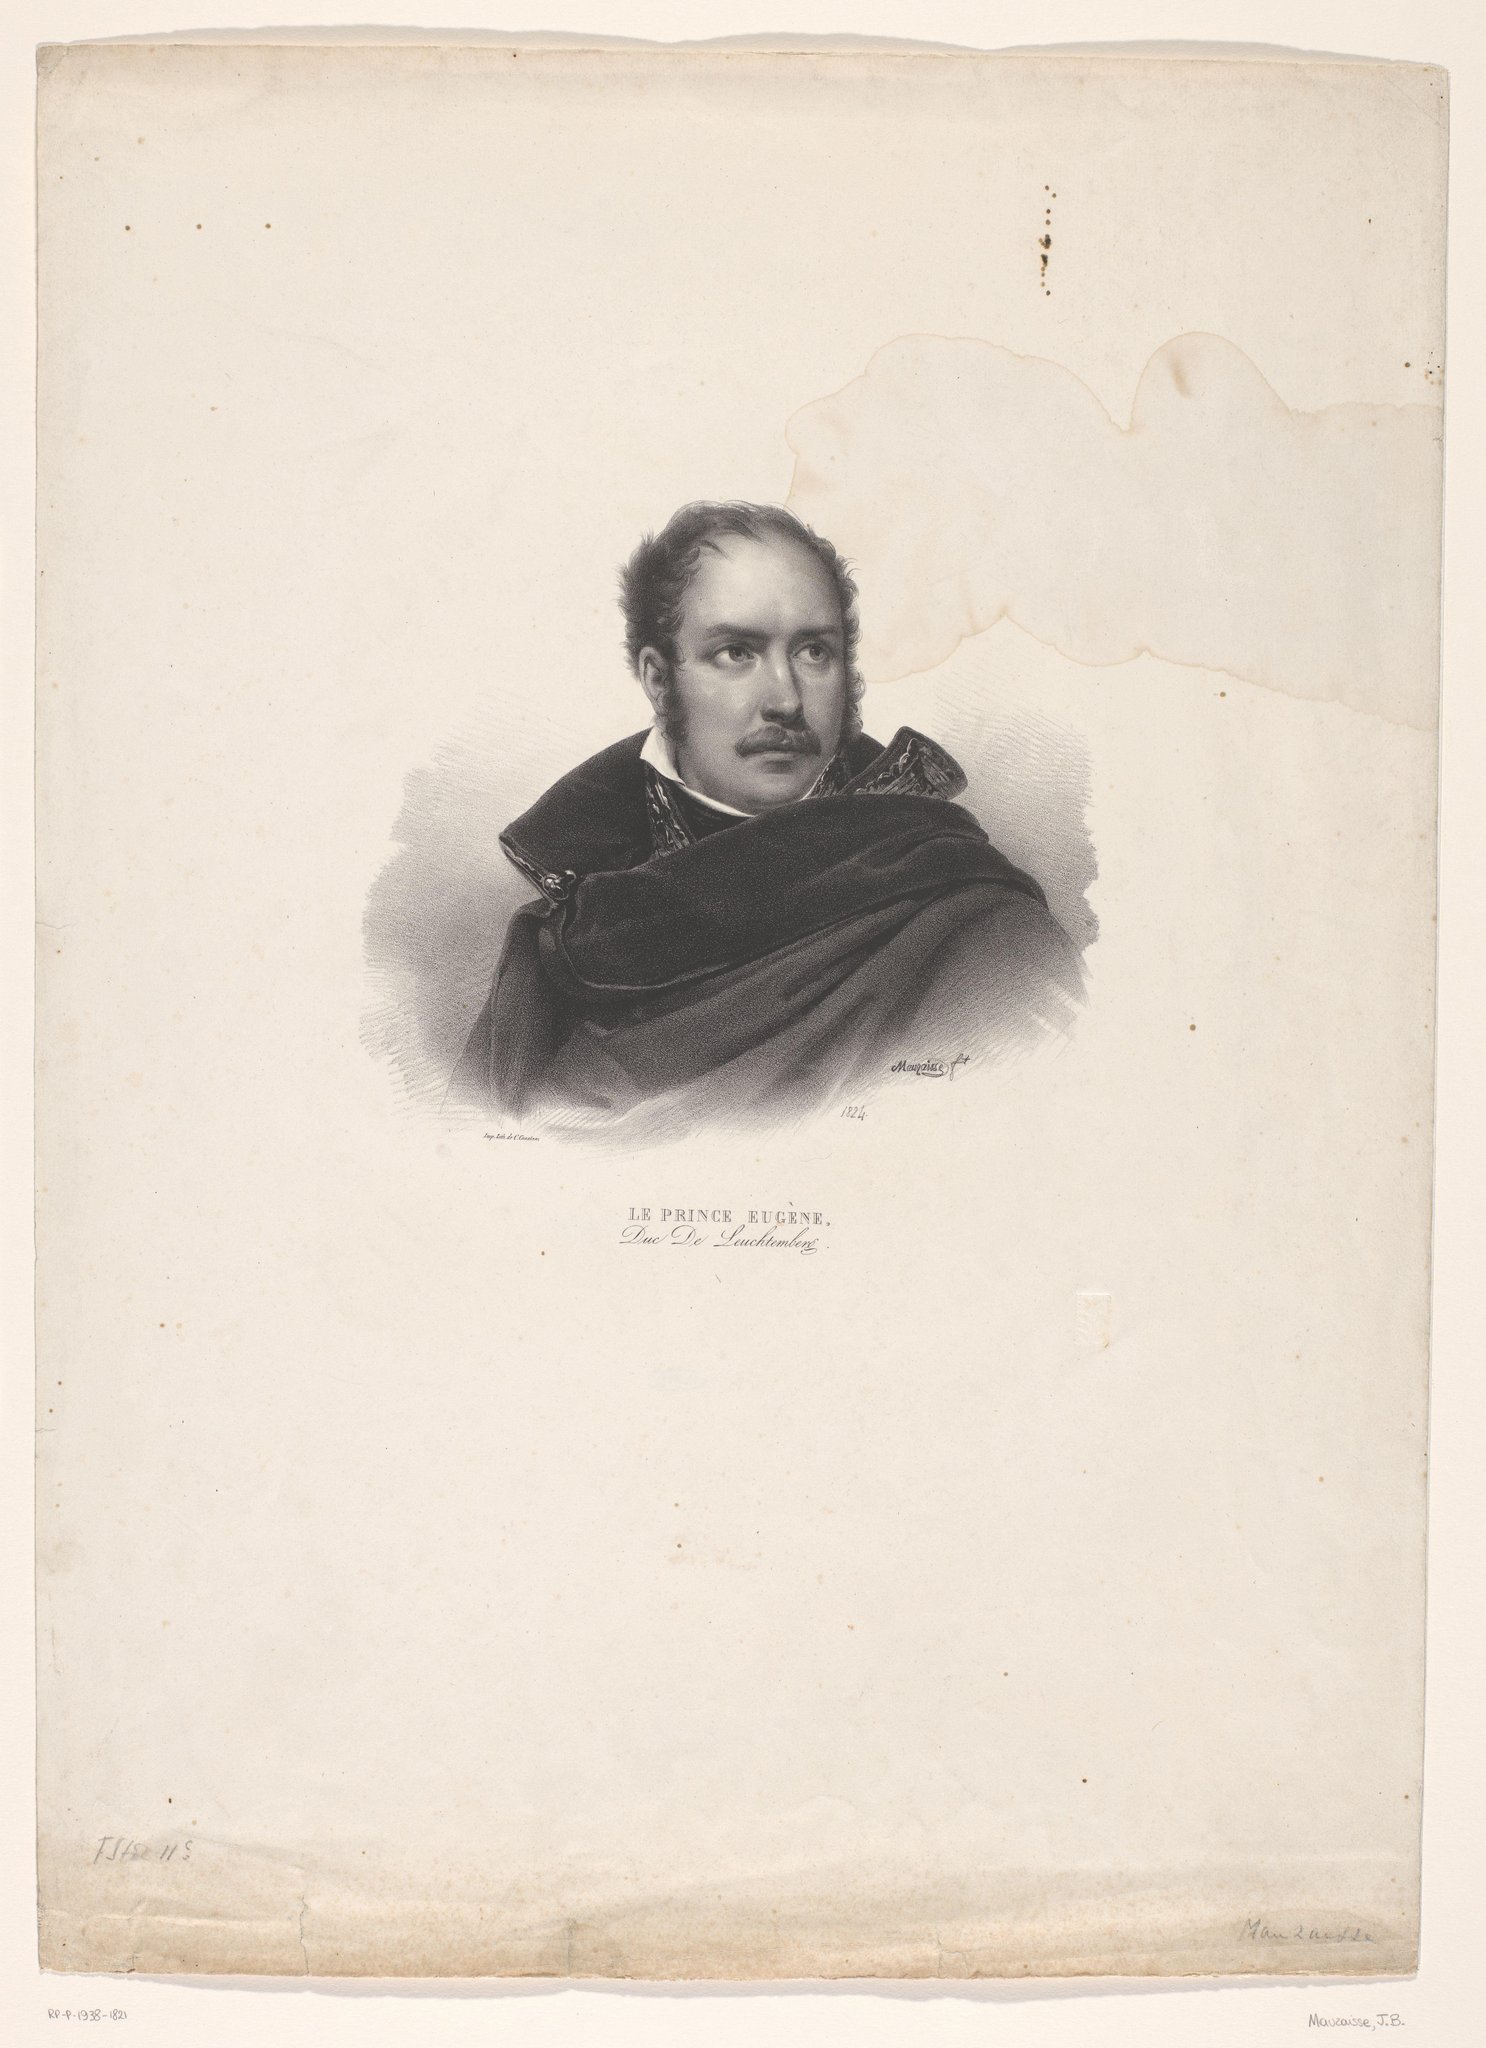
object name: print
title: Le prince Eugène, duc de Leuchtenberg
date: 1824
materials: paper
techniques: lithograph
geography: paris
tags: paris, eugène de beauharnais, historical persons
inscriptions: check stamp:, collector's mark: Lugt 2228